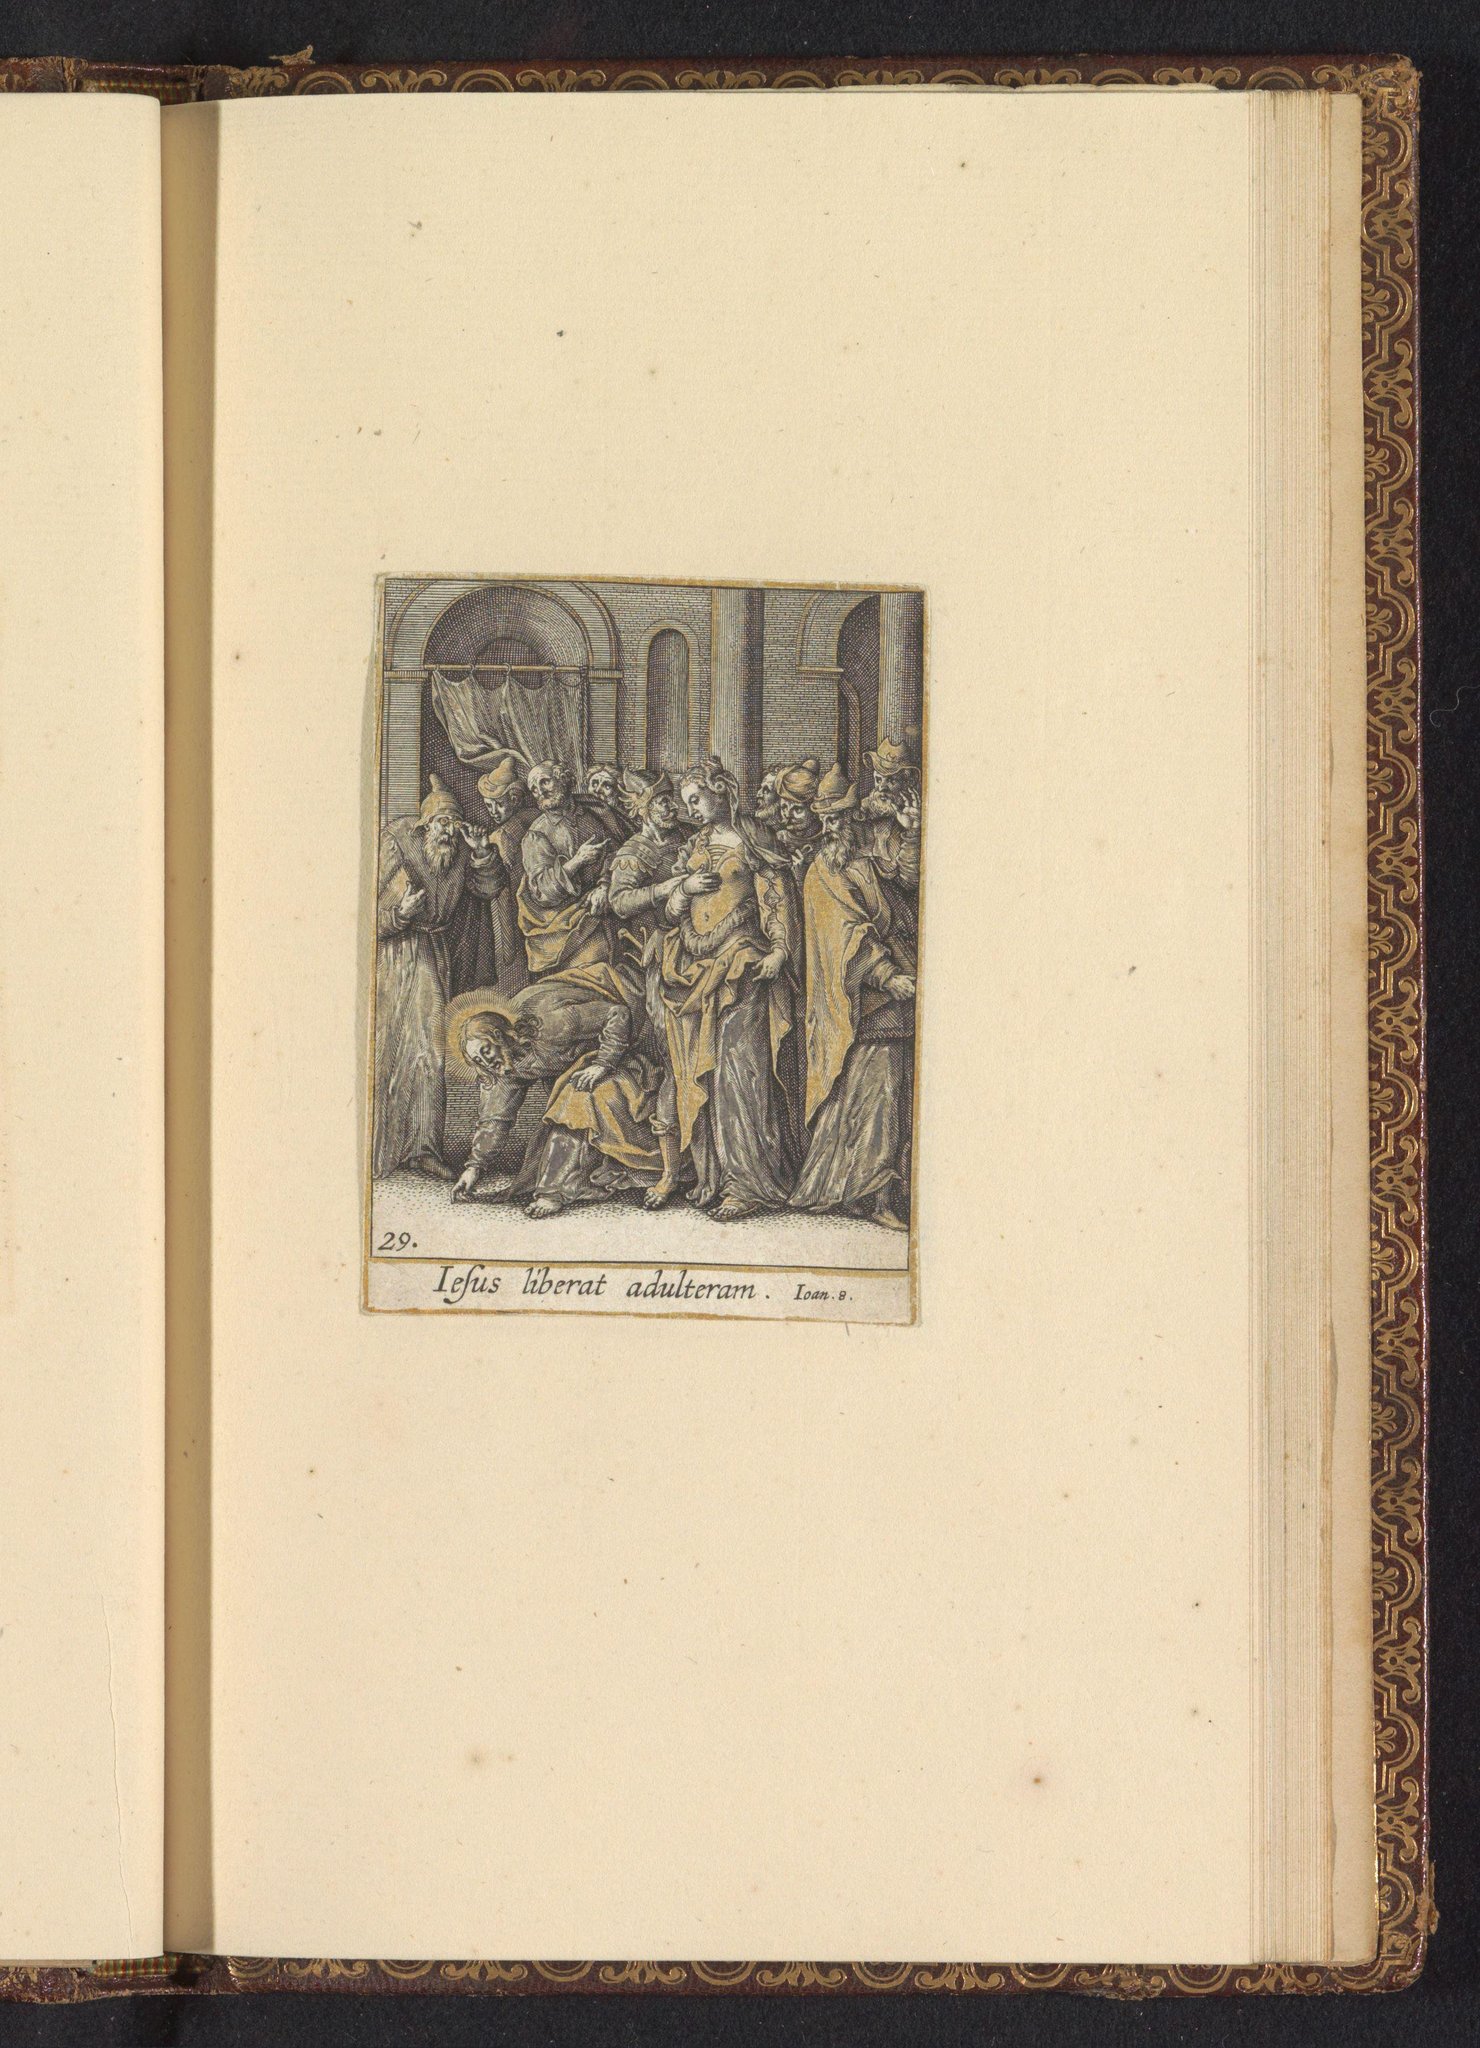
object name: print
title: Vita Iesu Salvatoris varijs iconibus ab Adriano Collaert expressa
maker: adriaen collaert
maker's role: draughtsman, print maker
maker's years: 1560-1618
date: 1580-1590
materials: gold, paper, silver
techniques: engraving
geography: antwerp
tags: pharisees bring a woman accused of adultery before christ (john 8:2-11)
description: De gravures van beide reeksen zijn door dezelfde hand gehoogd met goud en zilver. De eerste reeks van 34 (van 35) gravures is een verkleinde versie naar prenten uit een reeks naar Maarten de Vos (nrs. 2-28, 31-33) met toevoeging van drie scènes uit de Wonderen van Christus (nrs. 26, 28, 30).